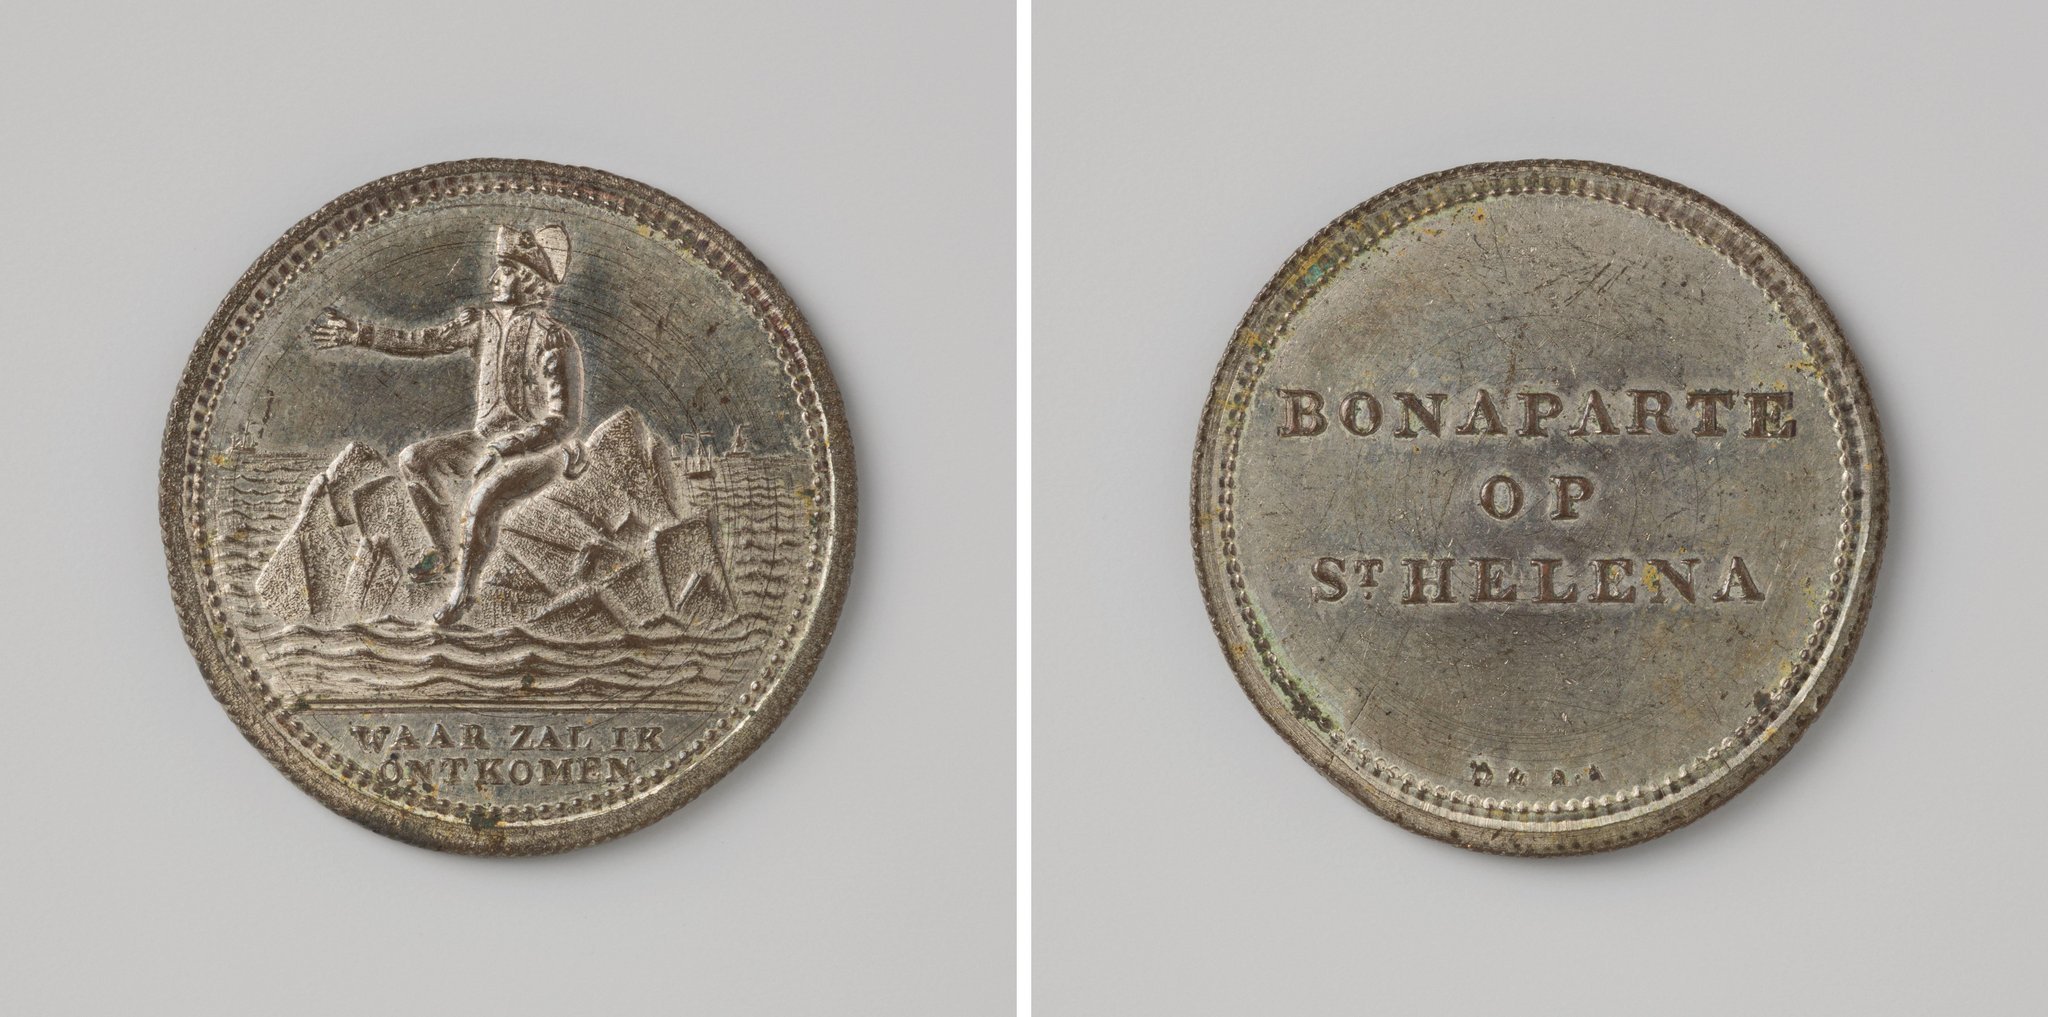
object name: history medal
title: Verbanning van Napoleon Bonaparte naar St. Helena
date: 1815-1821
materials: alloy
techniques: striking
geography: paris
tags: napoleon i (emperor of the french)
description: Penning. Voorzijde: Napoleon zittend op rotsen midden in zee; afsnede: opschrift. Keerzijde: opschrift.